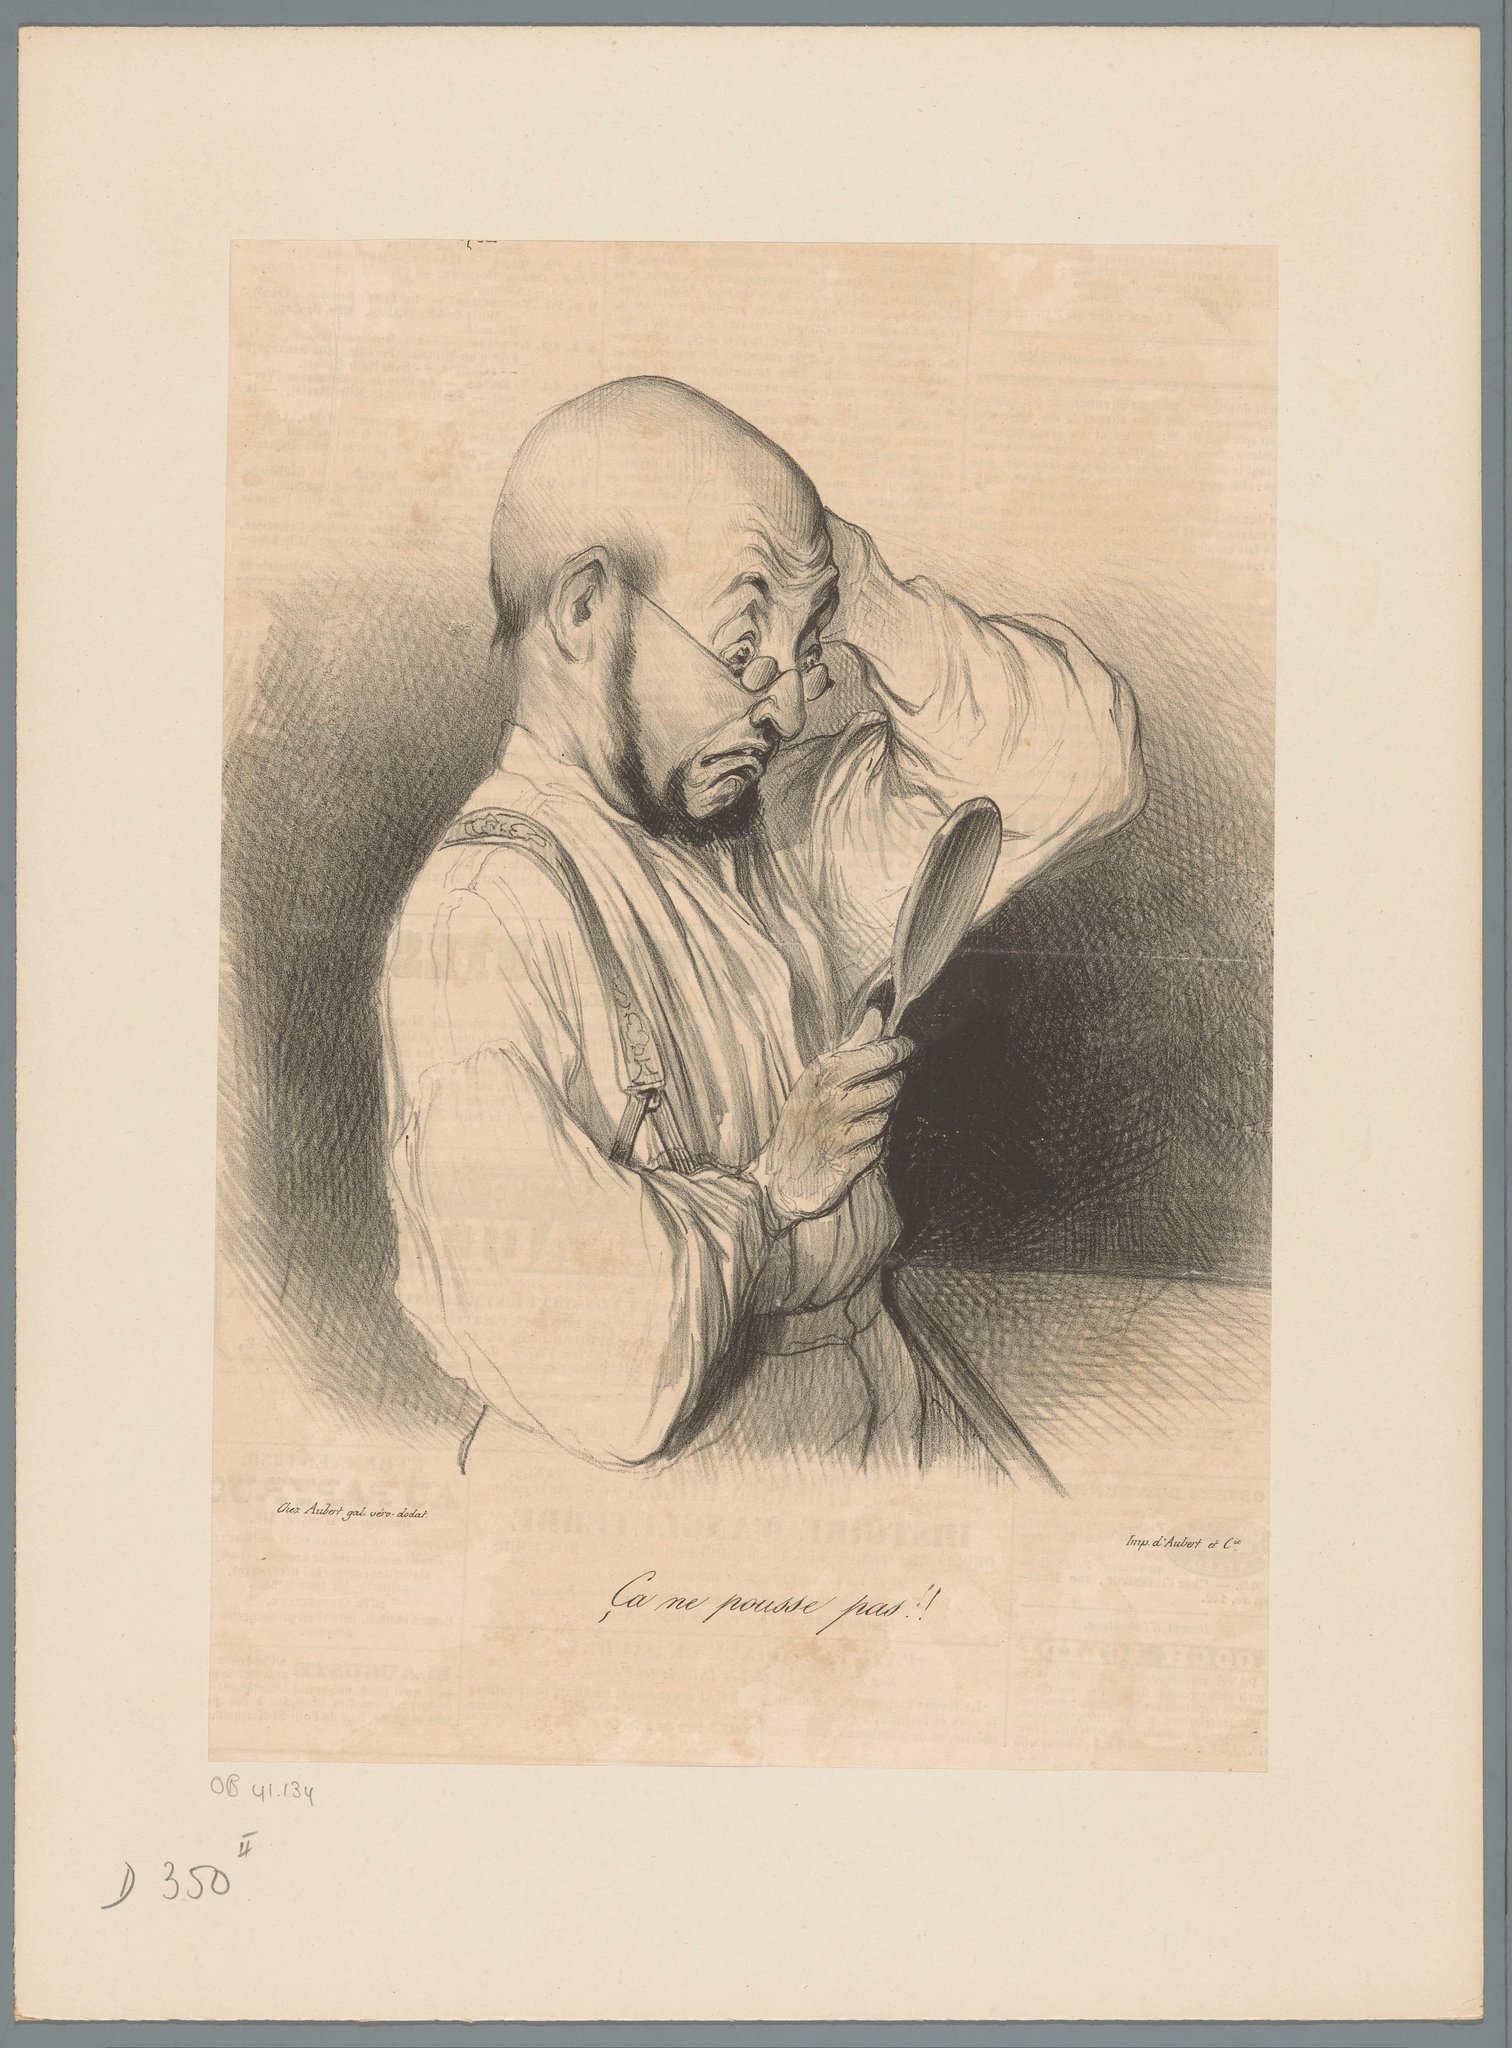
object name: cartoon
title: Man met spiegel constateert zijn kaalheid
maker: honoré daumier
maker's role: draughtsman, painter, print maker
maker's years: 1808-1879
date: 1837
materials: paper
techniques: letterpress printing, lithograph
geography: paris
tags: caricatures (human types), looking in the mirror; contemplation of own beauty, baldness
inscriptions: collector's mark: Lugt 2228a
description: Prent mogelijk uit: Le Charivari, 29 december 1837.